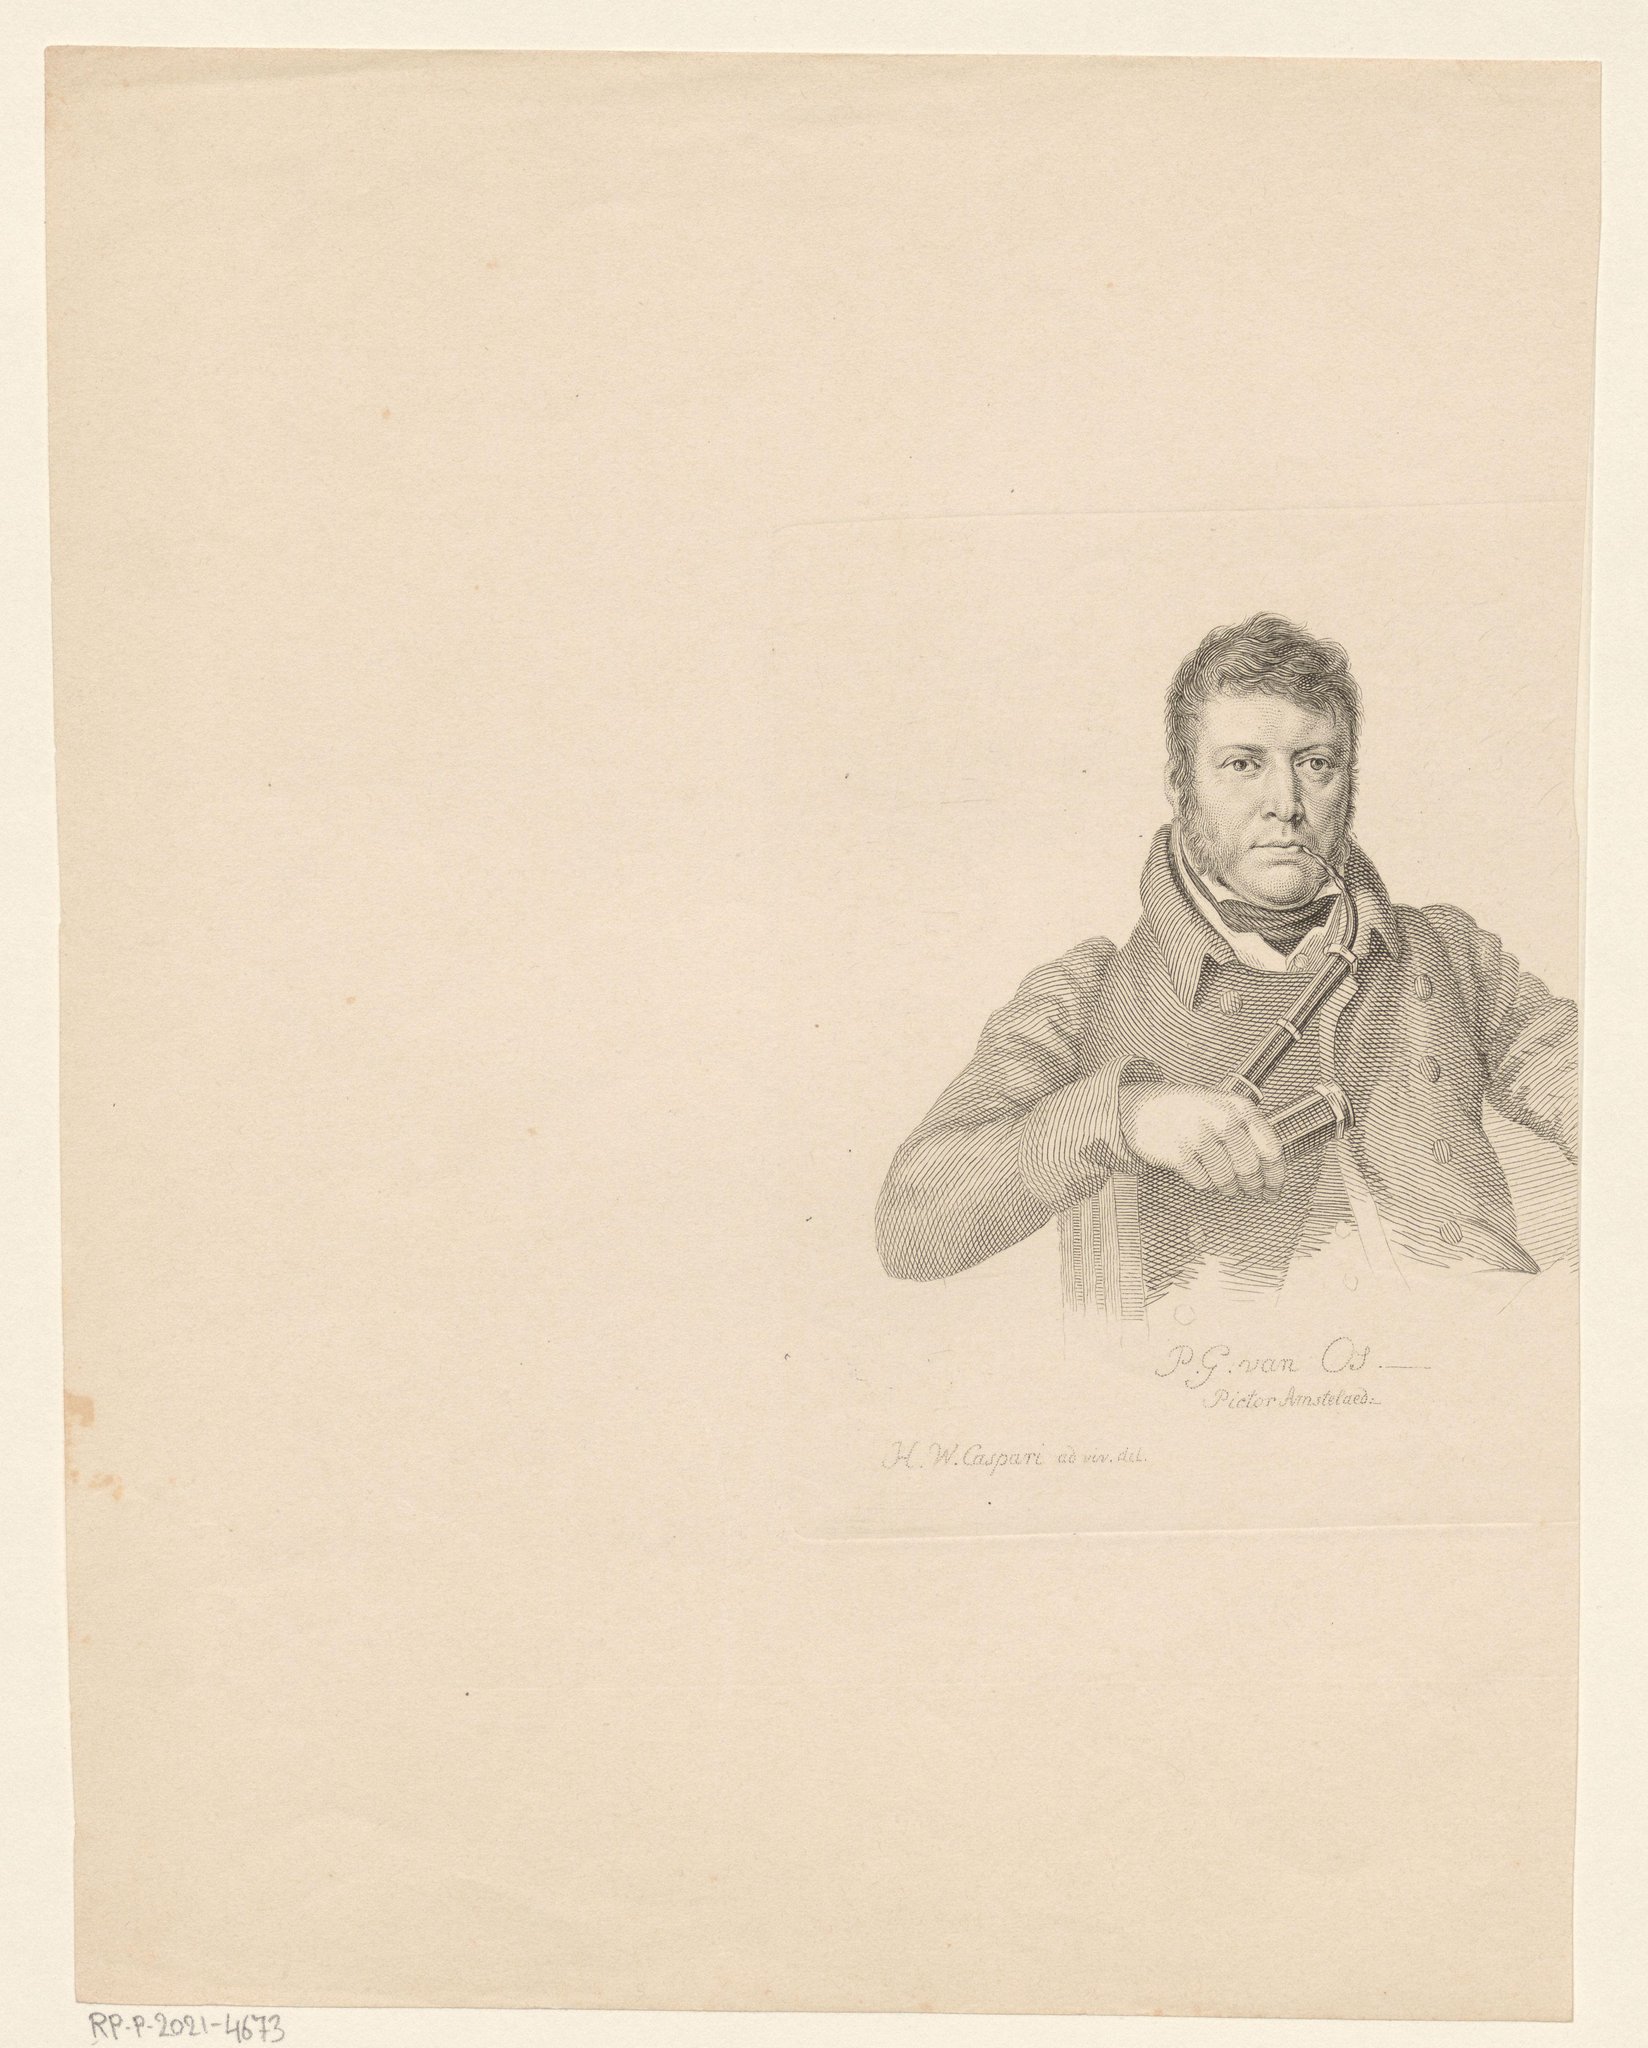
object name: print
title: Portret van Pieter Gerardus van Os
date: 1816-1826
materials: paper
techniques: etching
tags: painter, pieter gerardus van os, historical persons, portrait, self-portrait of painter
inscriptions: collector's mark: Lugt 2228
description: Serie voor het eerst uitgegeven door Jacob Ernst Marcus onder de titel Studiebeelden en Fragmenten, rond 1816. Later heruitgegeven in: Etudes gravées. Amsterdam: S. de Grebber, [1826].